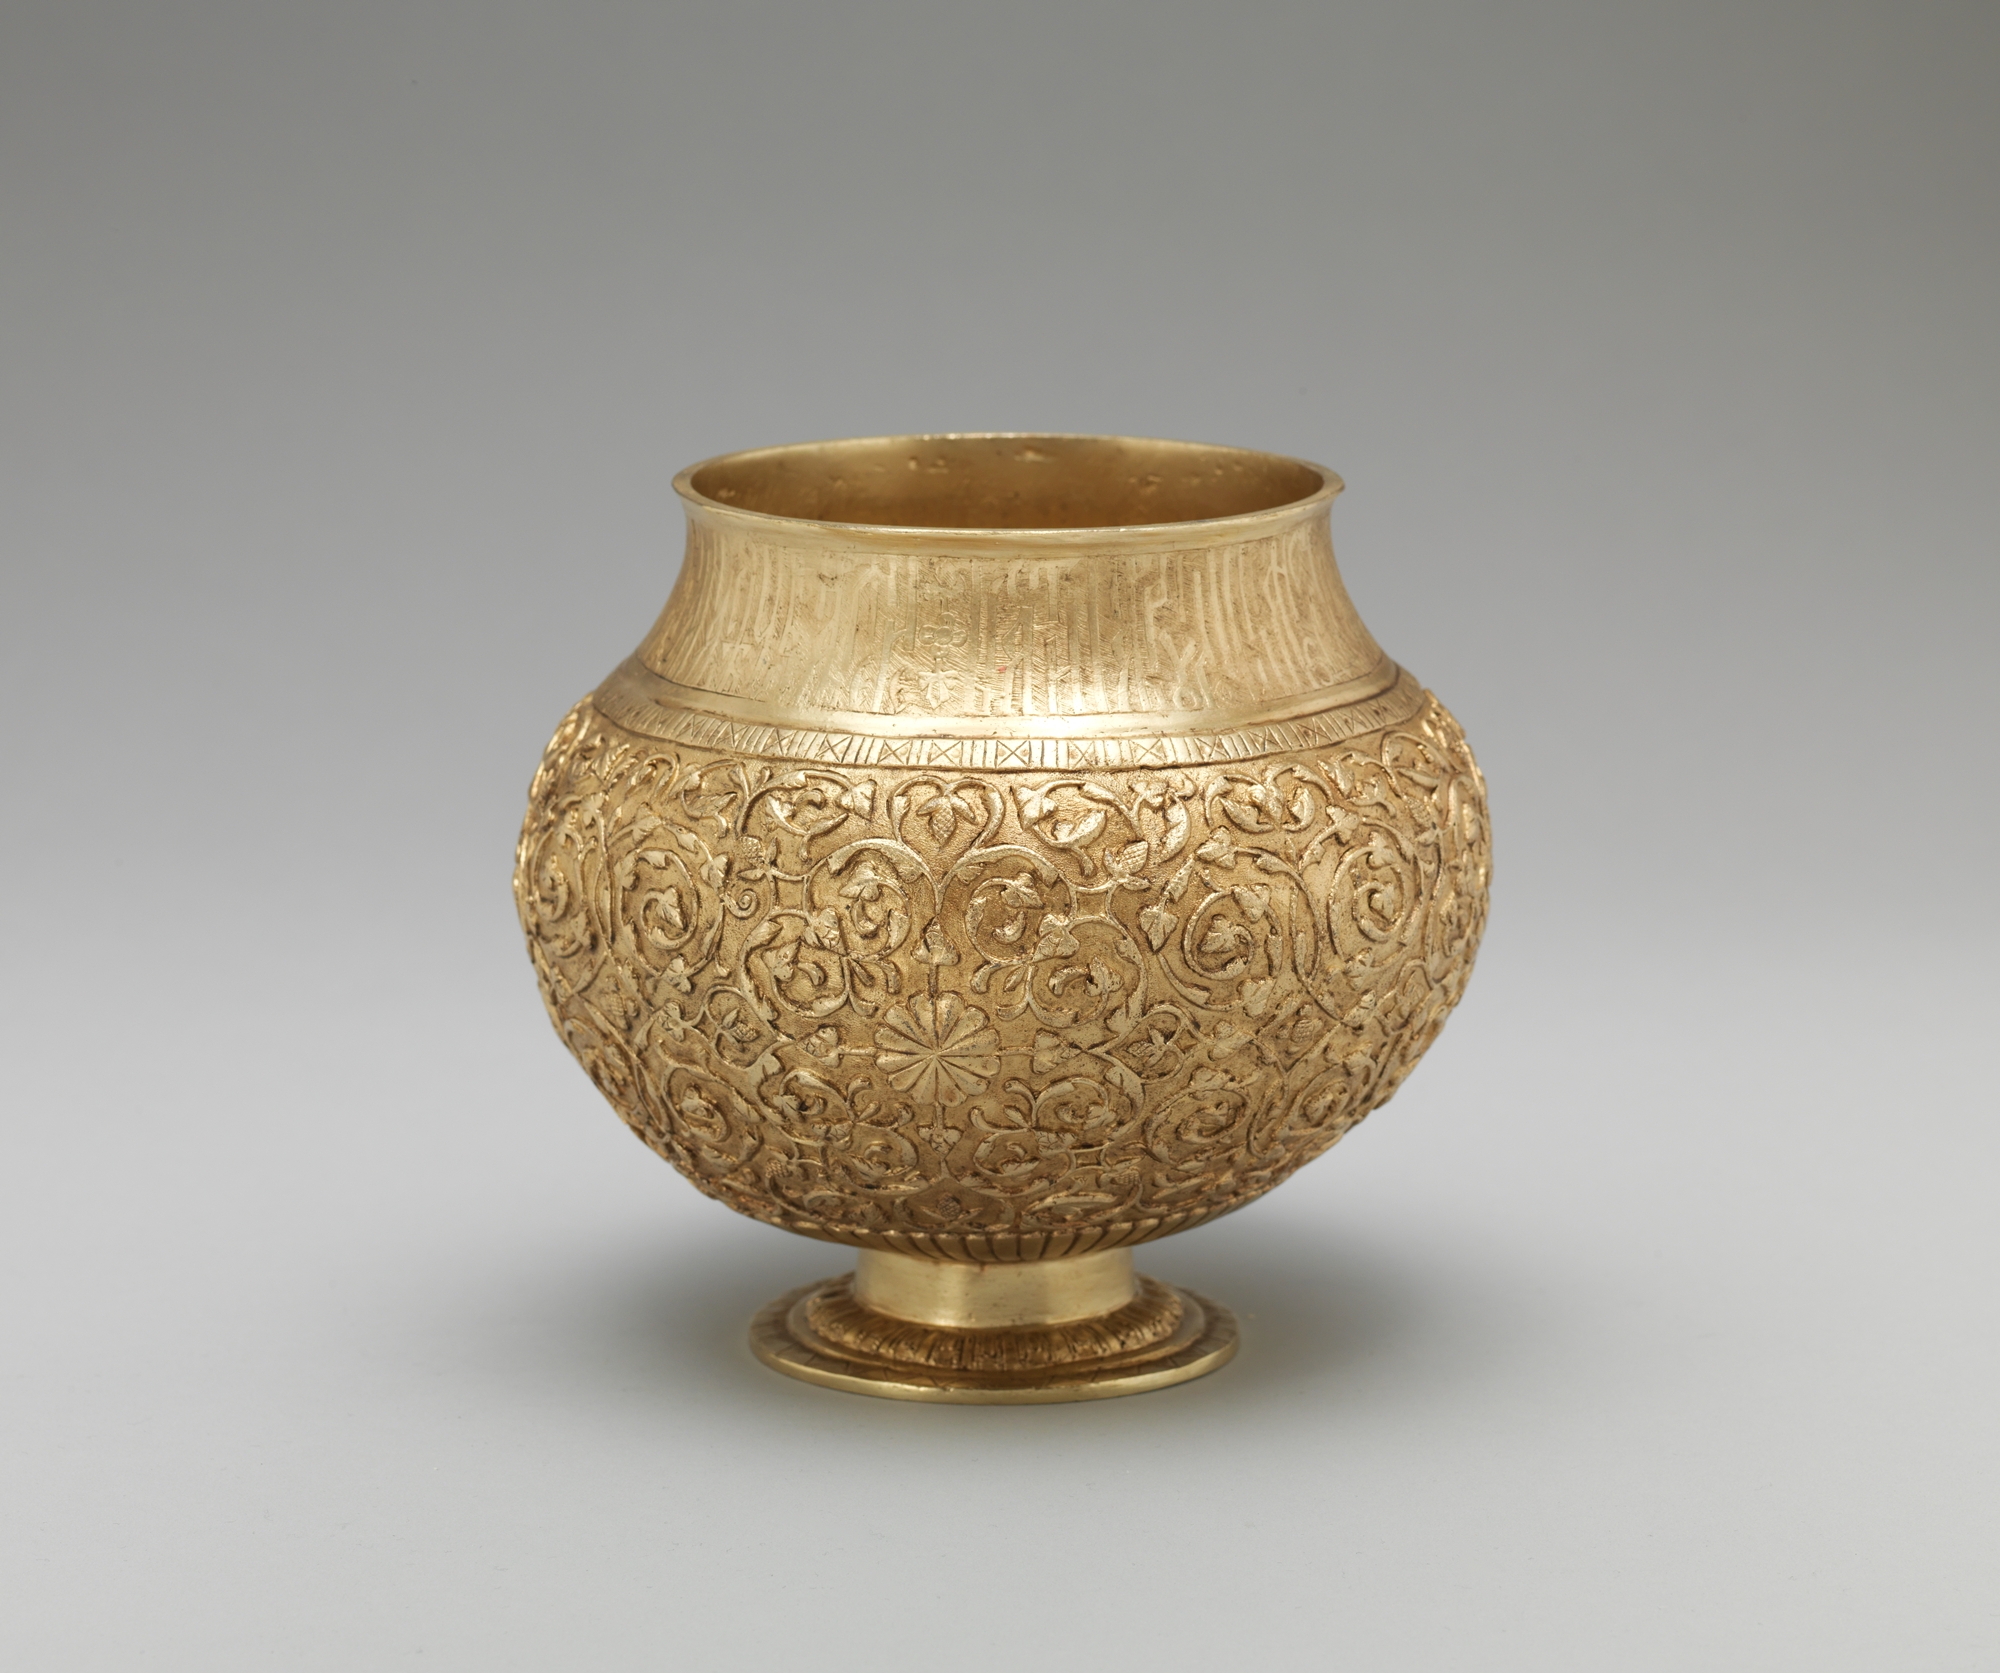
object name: bratina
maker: elkington & co.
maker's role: manufacturer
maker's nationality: british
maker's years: 1829-1963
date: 1801-1900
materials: metal, silver